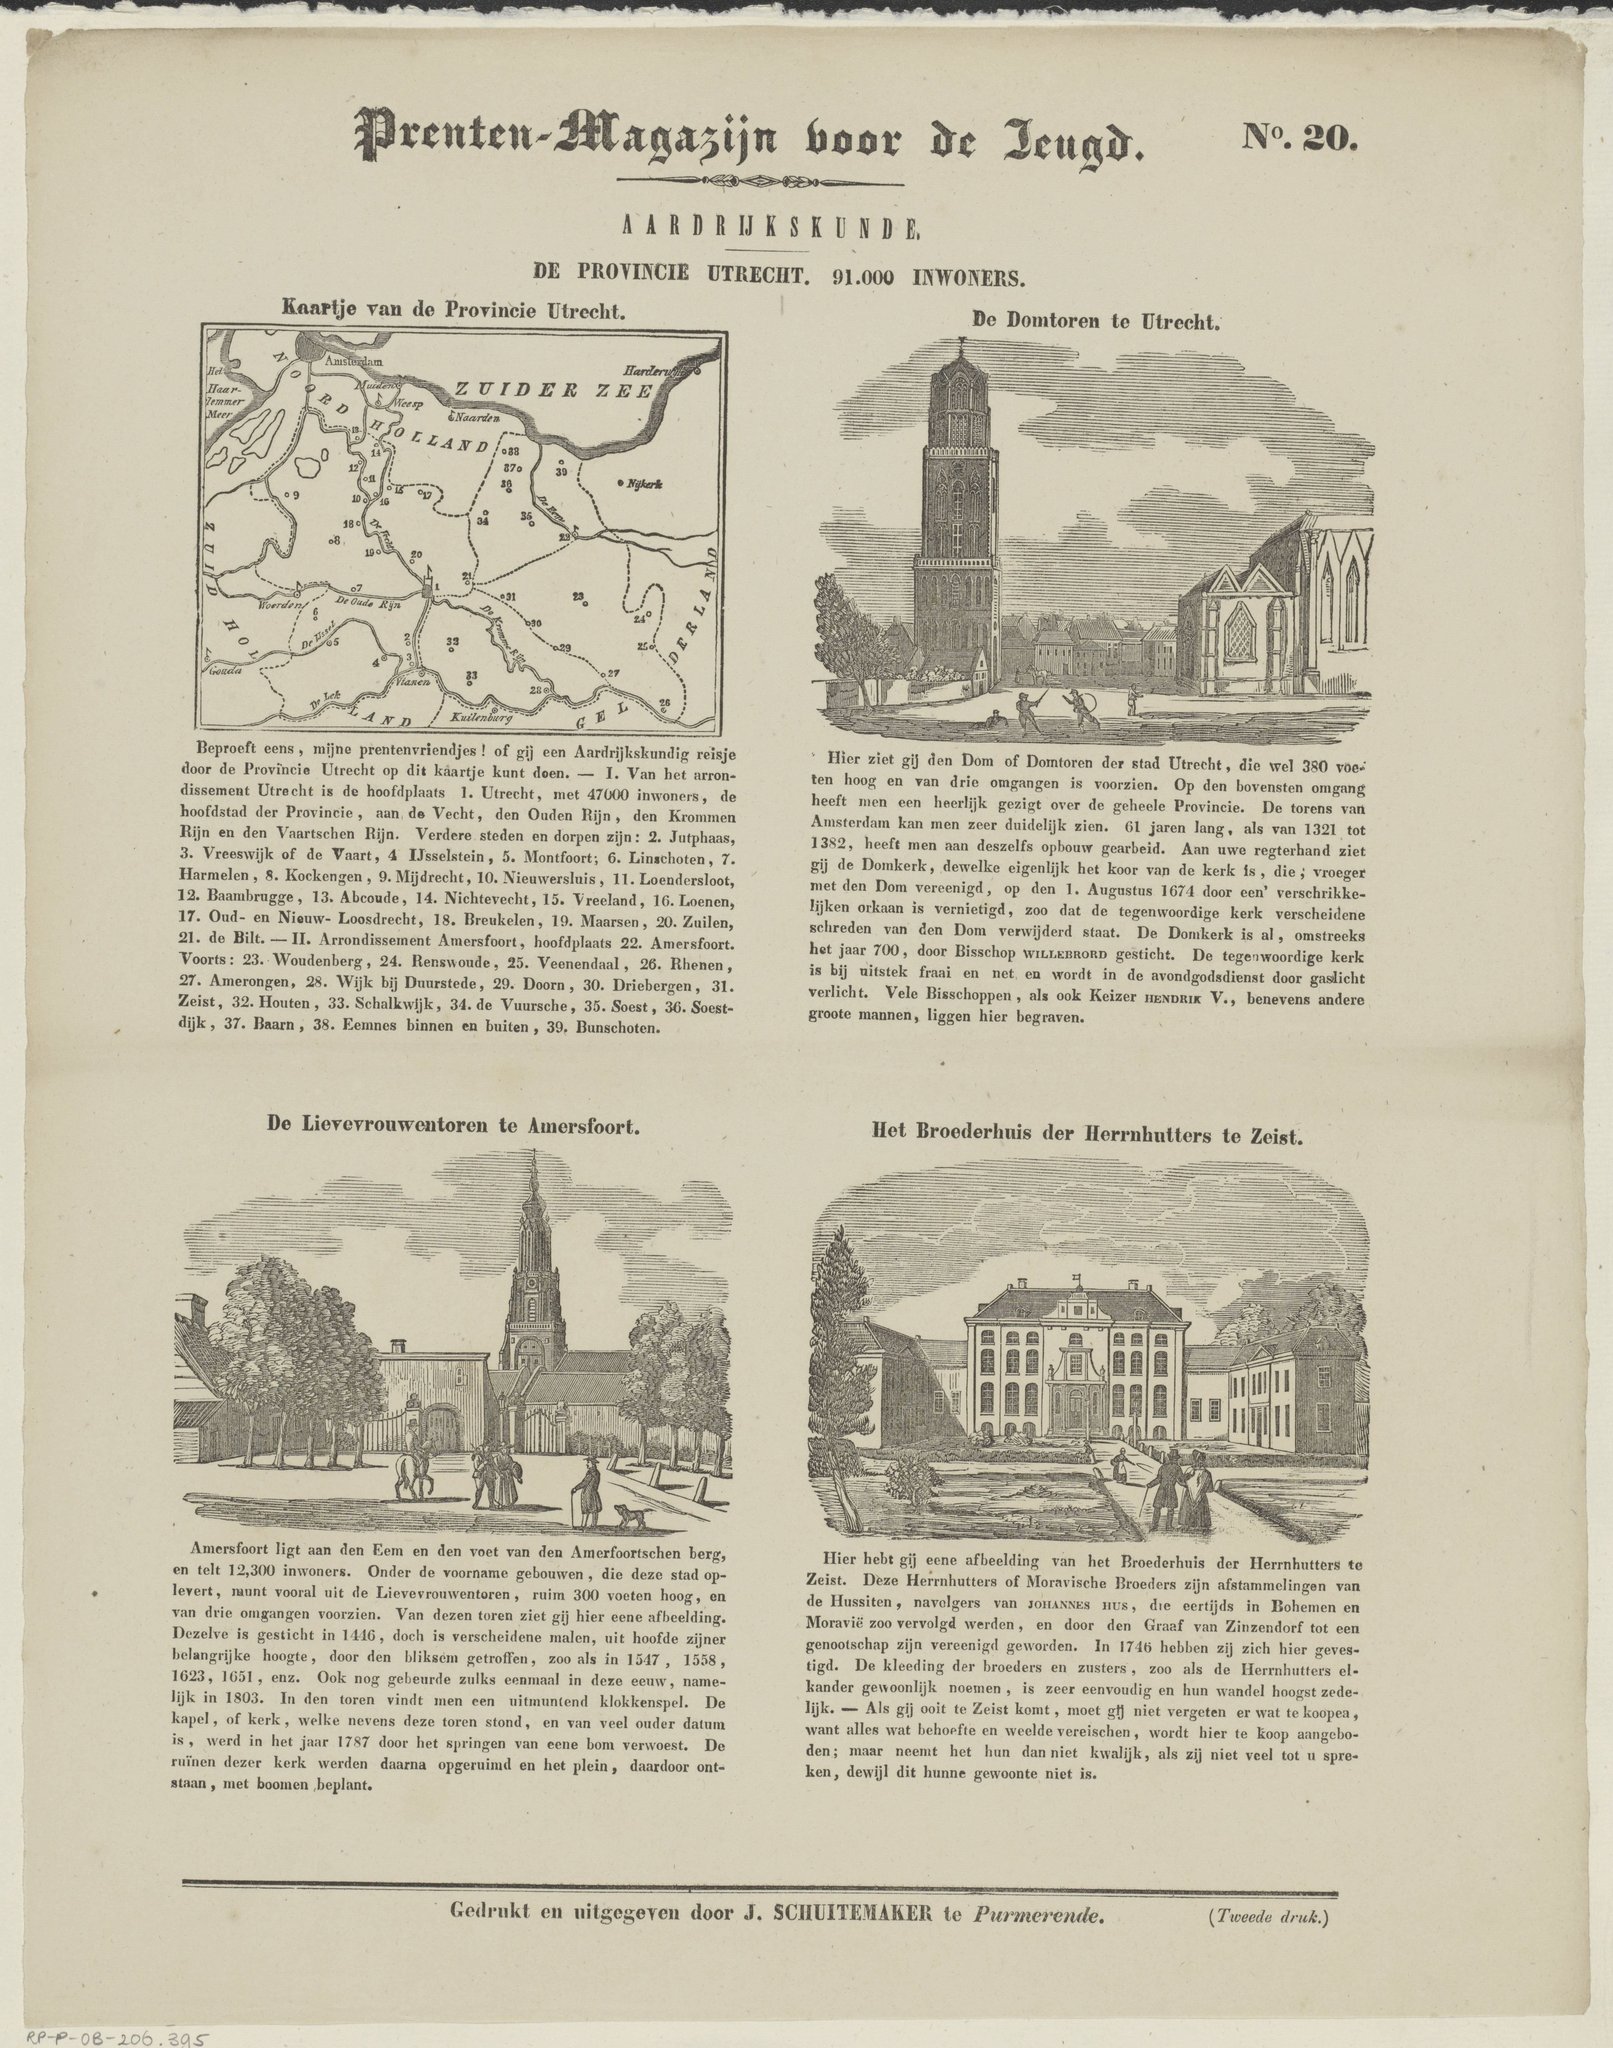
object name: print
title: Prenten-magazijn voor de jeugd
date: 1842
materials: paper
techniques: letterpress printing, engraving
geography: purmerend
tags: maps, atlases, utrecht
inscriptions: collector's mark: Lugt 2760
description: Blad met 4 voorstellingen over de provincie Utrecht met een kaart en belangrijke gebouwen: de Domtoren in Utrecht, de Onze-Lieve-Vrouwetoren in Amersfoort en Slot Zeist te Zeist. Boven elke voorstelling een titel en onder elke voorstelling een onderschrift. Genummerd rechtsboven: No. 20.